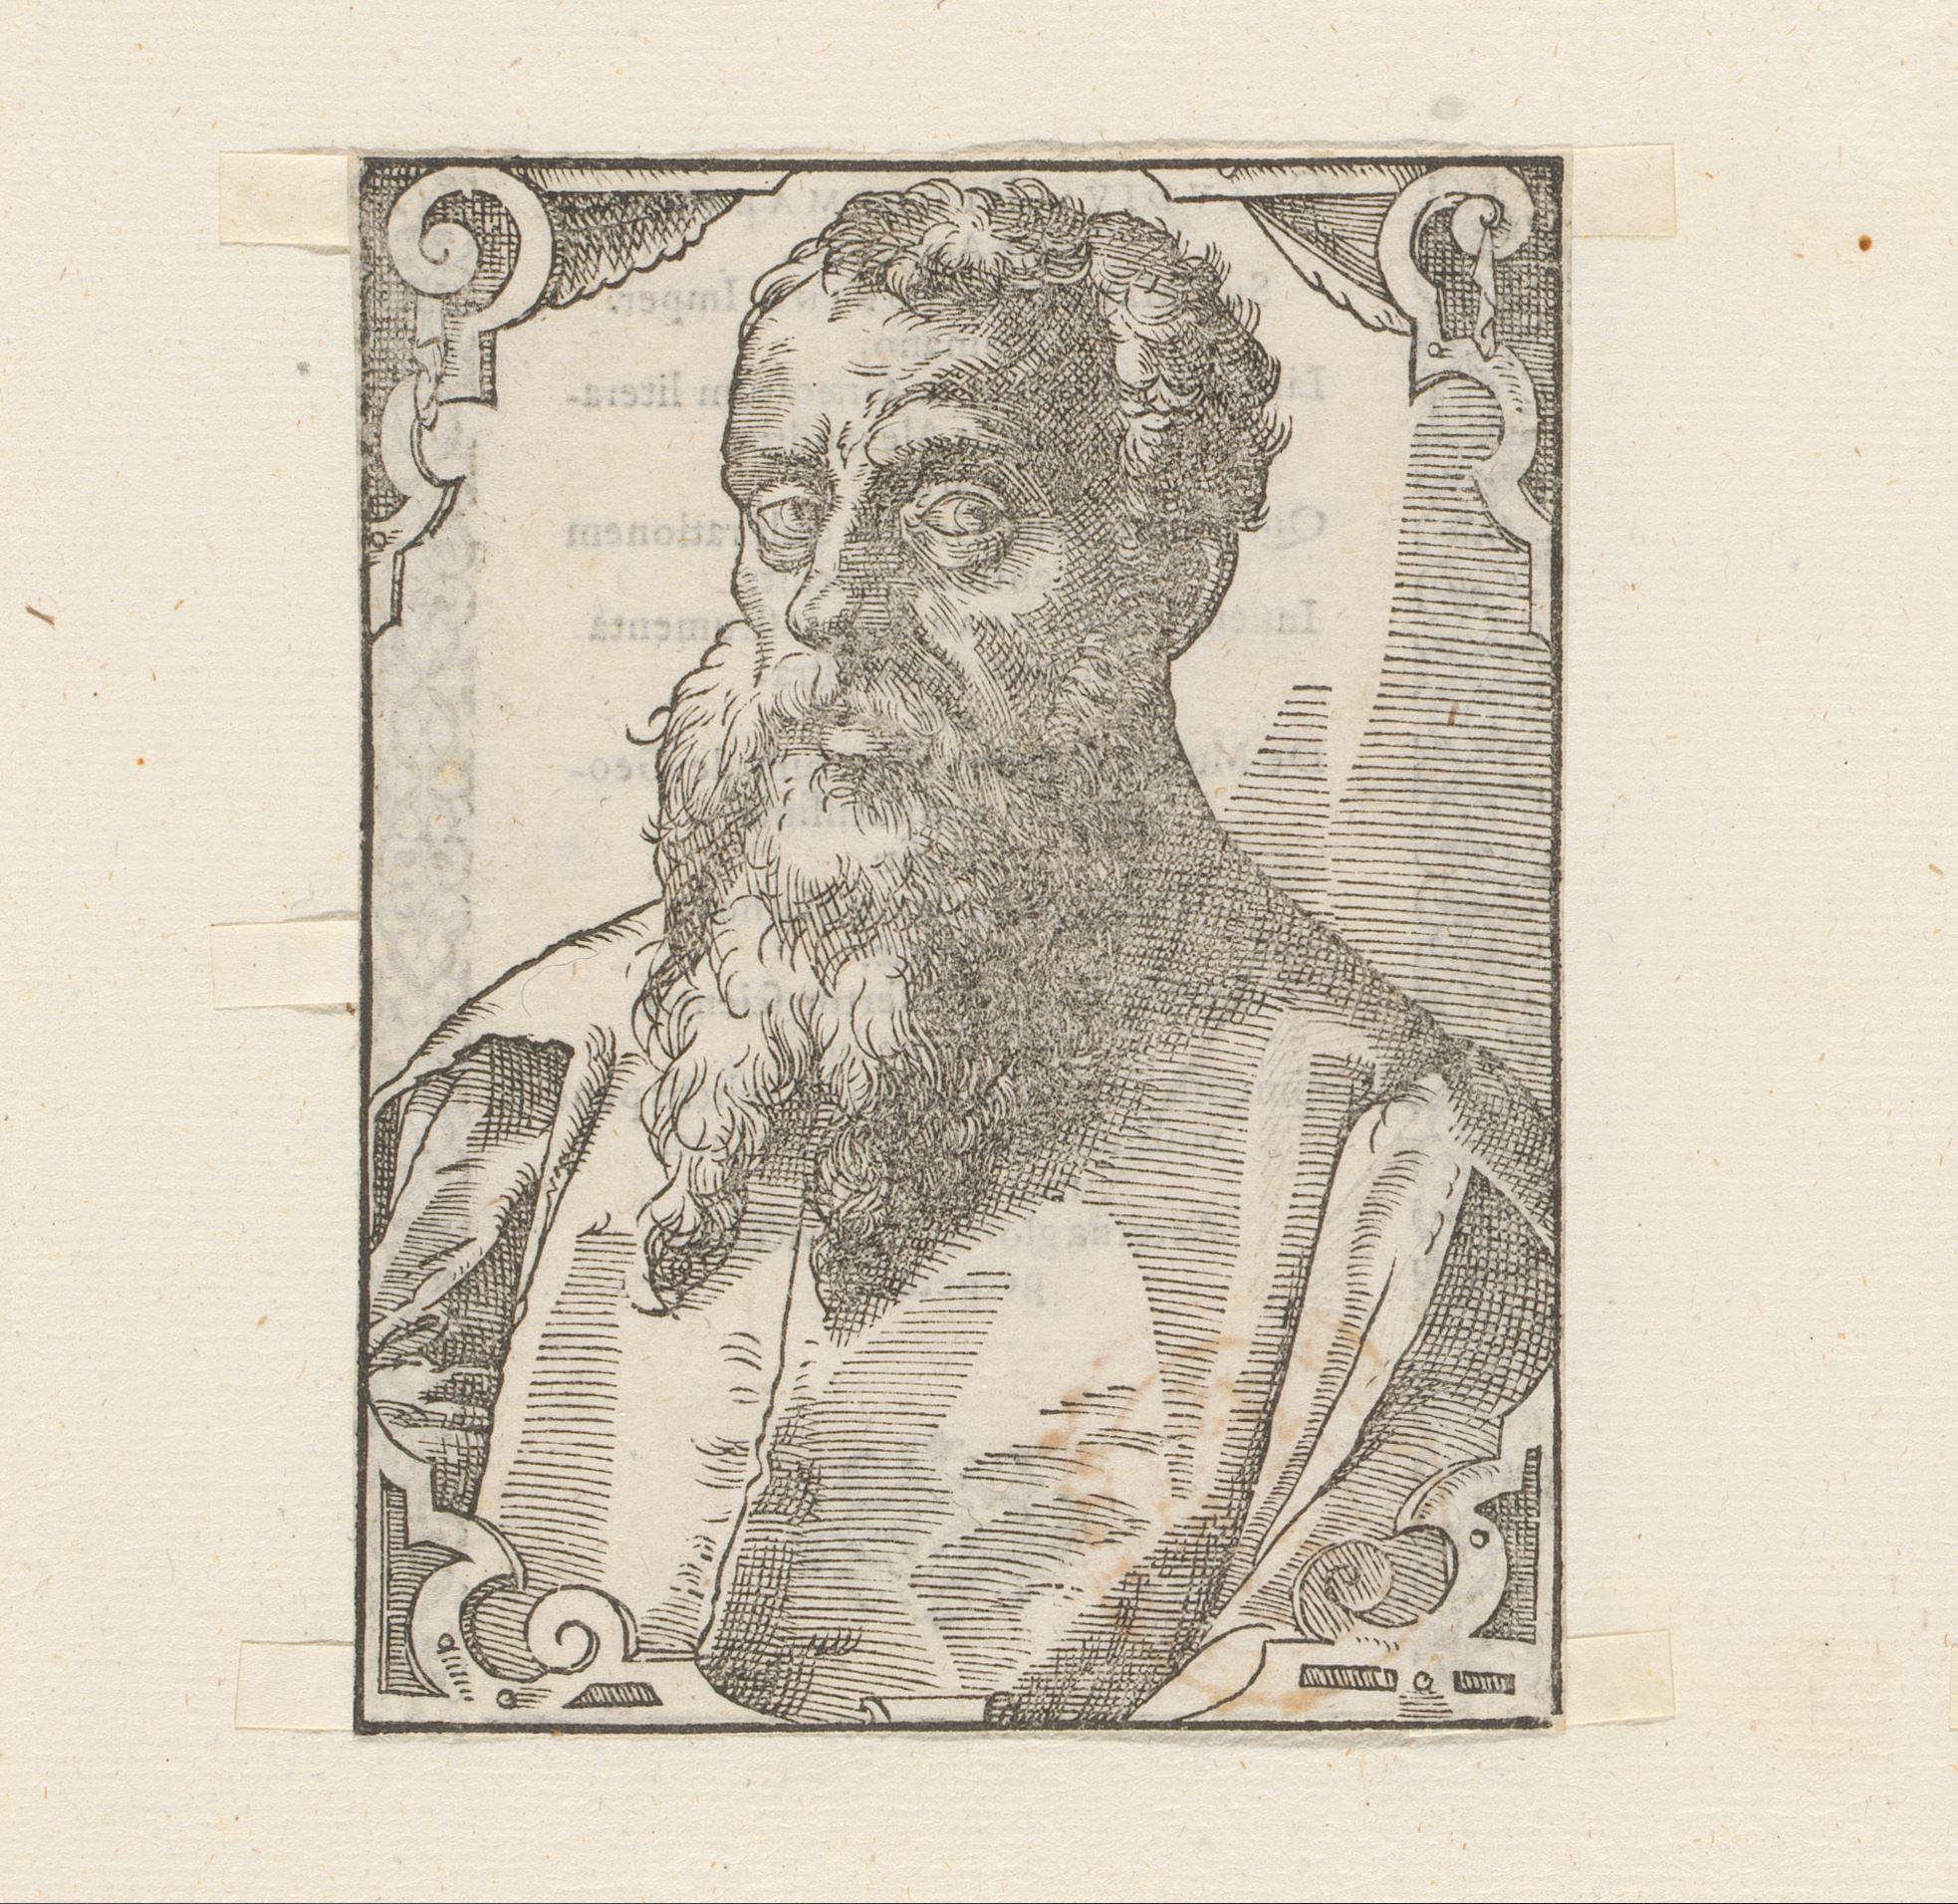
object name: book illustration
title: Portret van Claudius Ptolemeaus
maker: Anonymous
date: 1549-1584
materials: paper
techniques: letterpress printing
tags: historical persons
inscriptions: collector's mark: Lugt 240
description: Prent gebruikt in: Reusner, Nikolaus. Icones Sive Imagines Vivae. Bazel: Conrad Waldkirch, 1589.